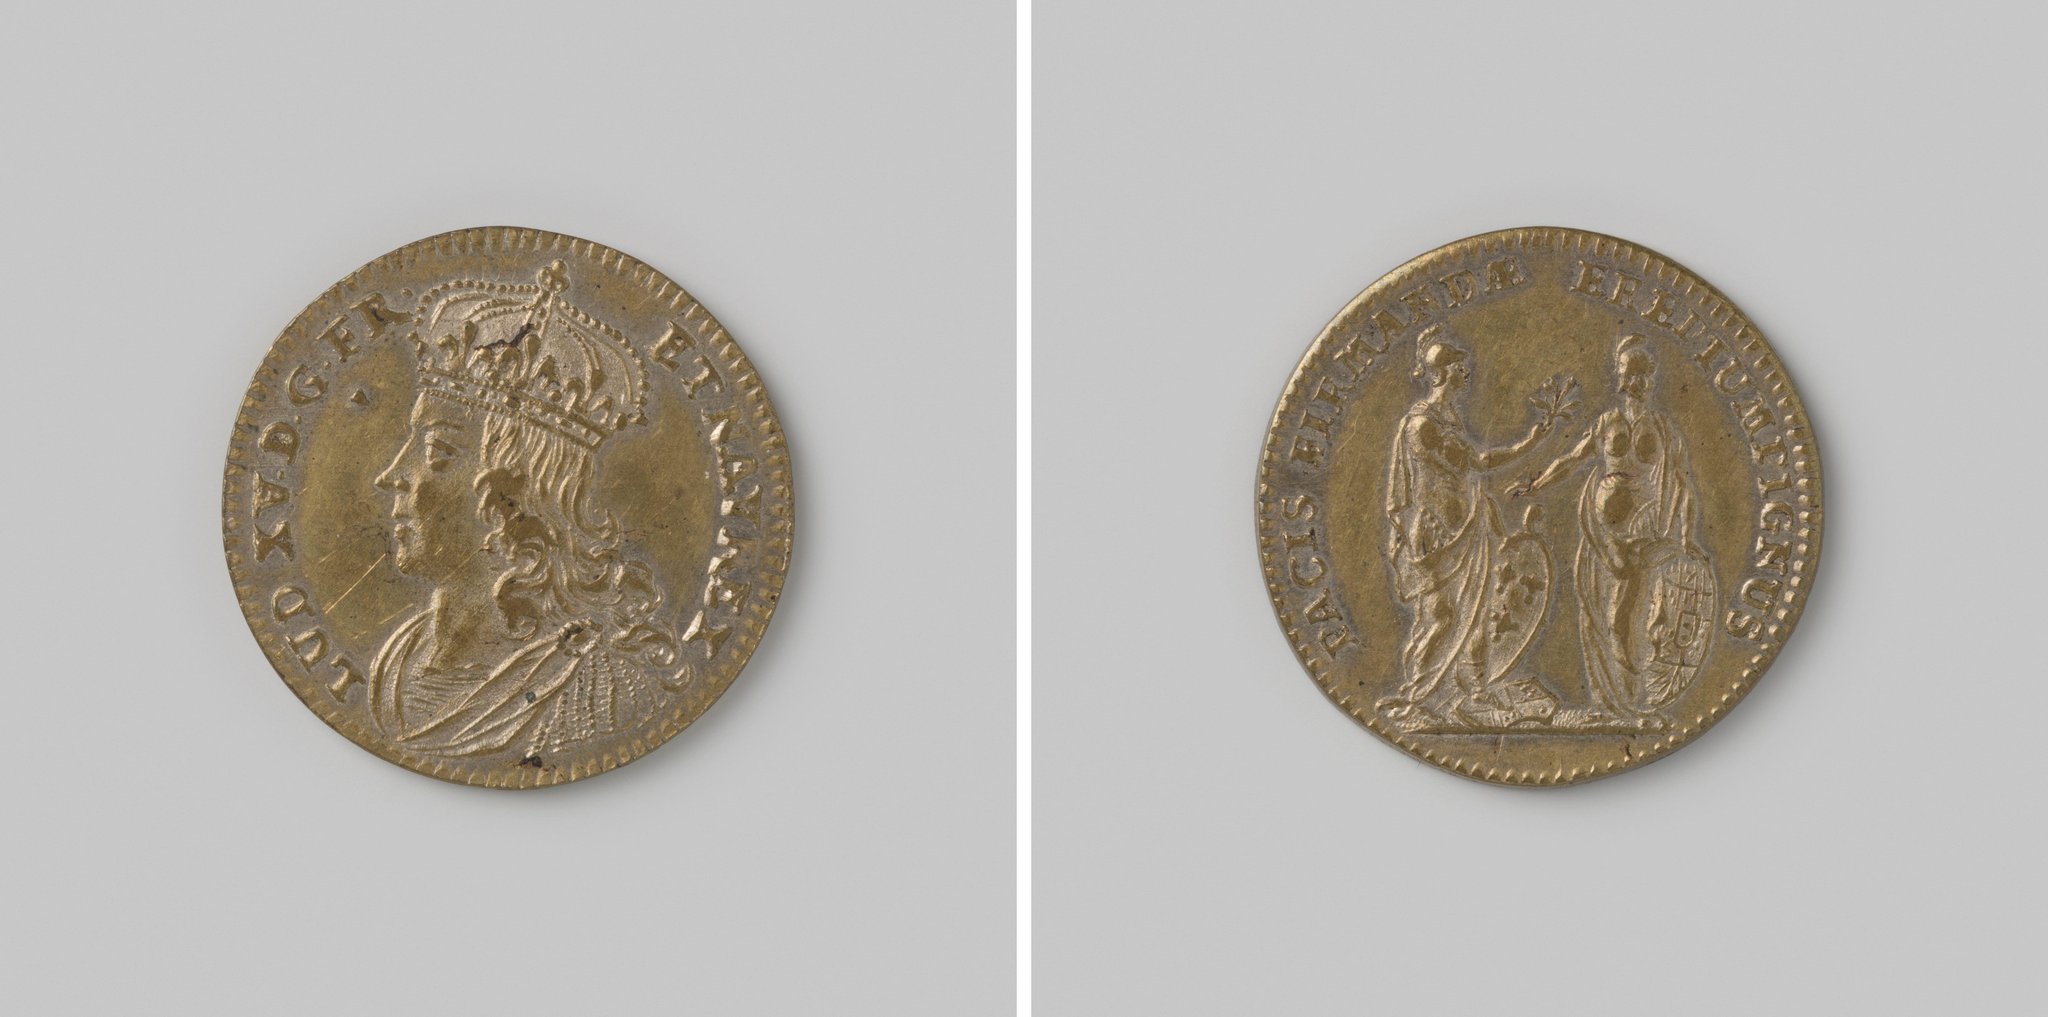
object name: history medal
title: Franse jeton op de vrede met Engeland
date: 1715-1774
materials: brass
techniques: striking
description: Messing penning, op de voorzijde het gekroonde borstbeeld van Lodewijk XV naar links met omschrift, op de keerzijde Frankrijk die Engeland een vredestak aanbiedt, met omschrift.